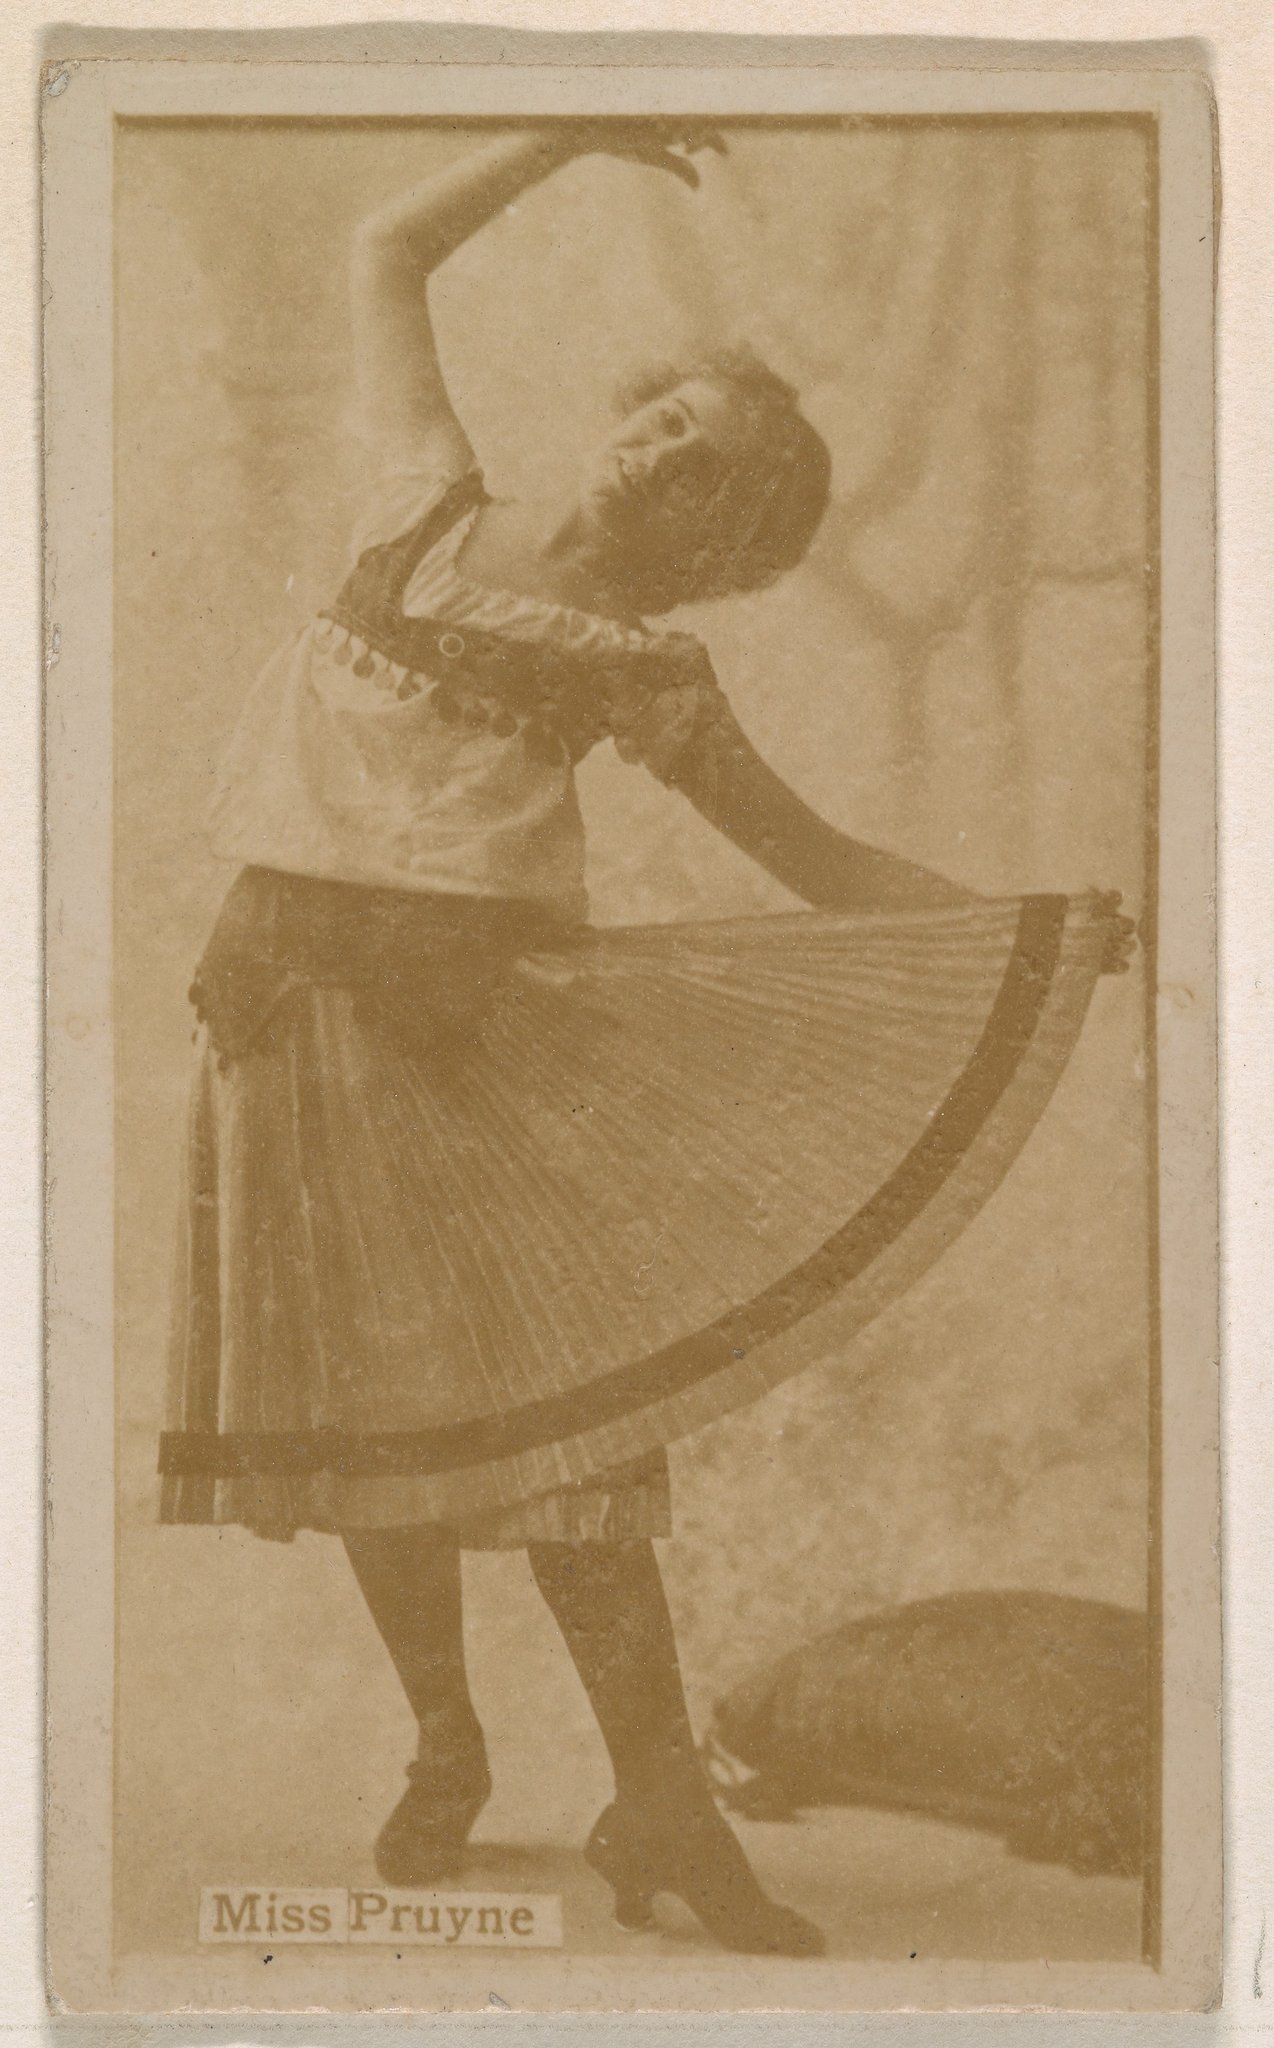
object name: photograph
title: Bertie Pruyne, from the Actresses series (N245) issued by Kinney Brothers to promote Sweet Caporal Cigarettes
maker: kinney brothers tobacco company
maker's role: publisher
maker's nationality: american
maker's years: 1869-2011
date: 1890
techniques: albumen silver print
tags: portraits,women,actresses